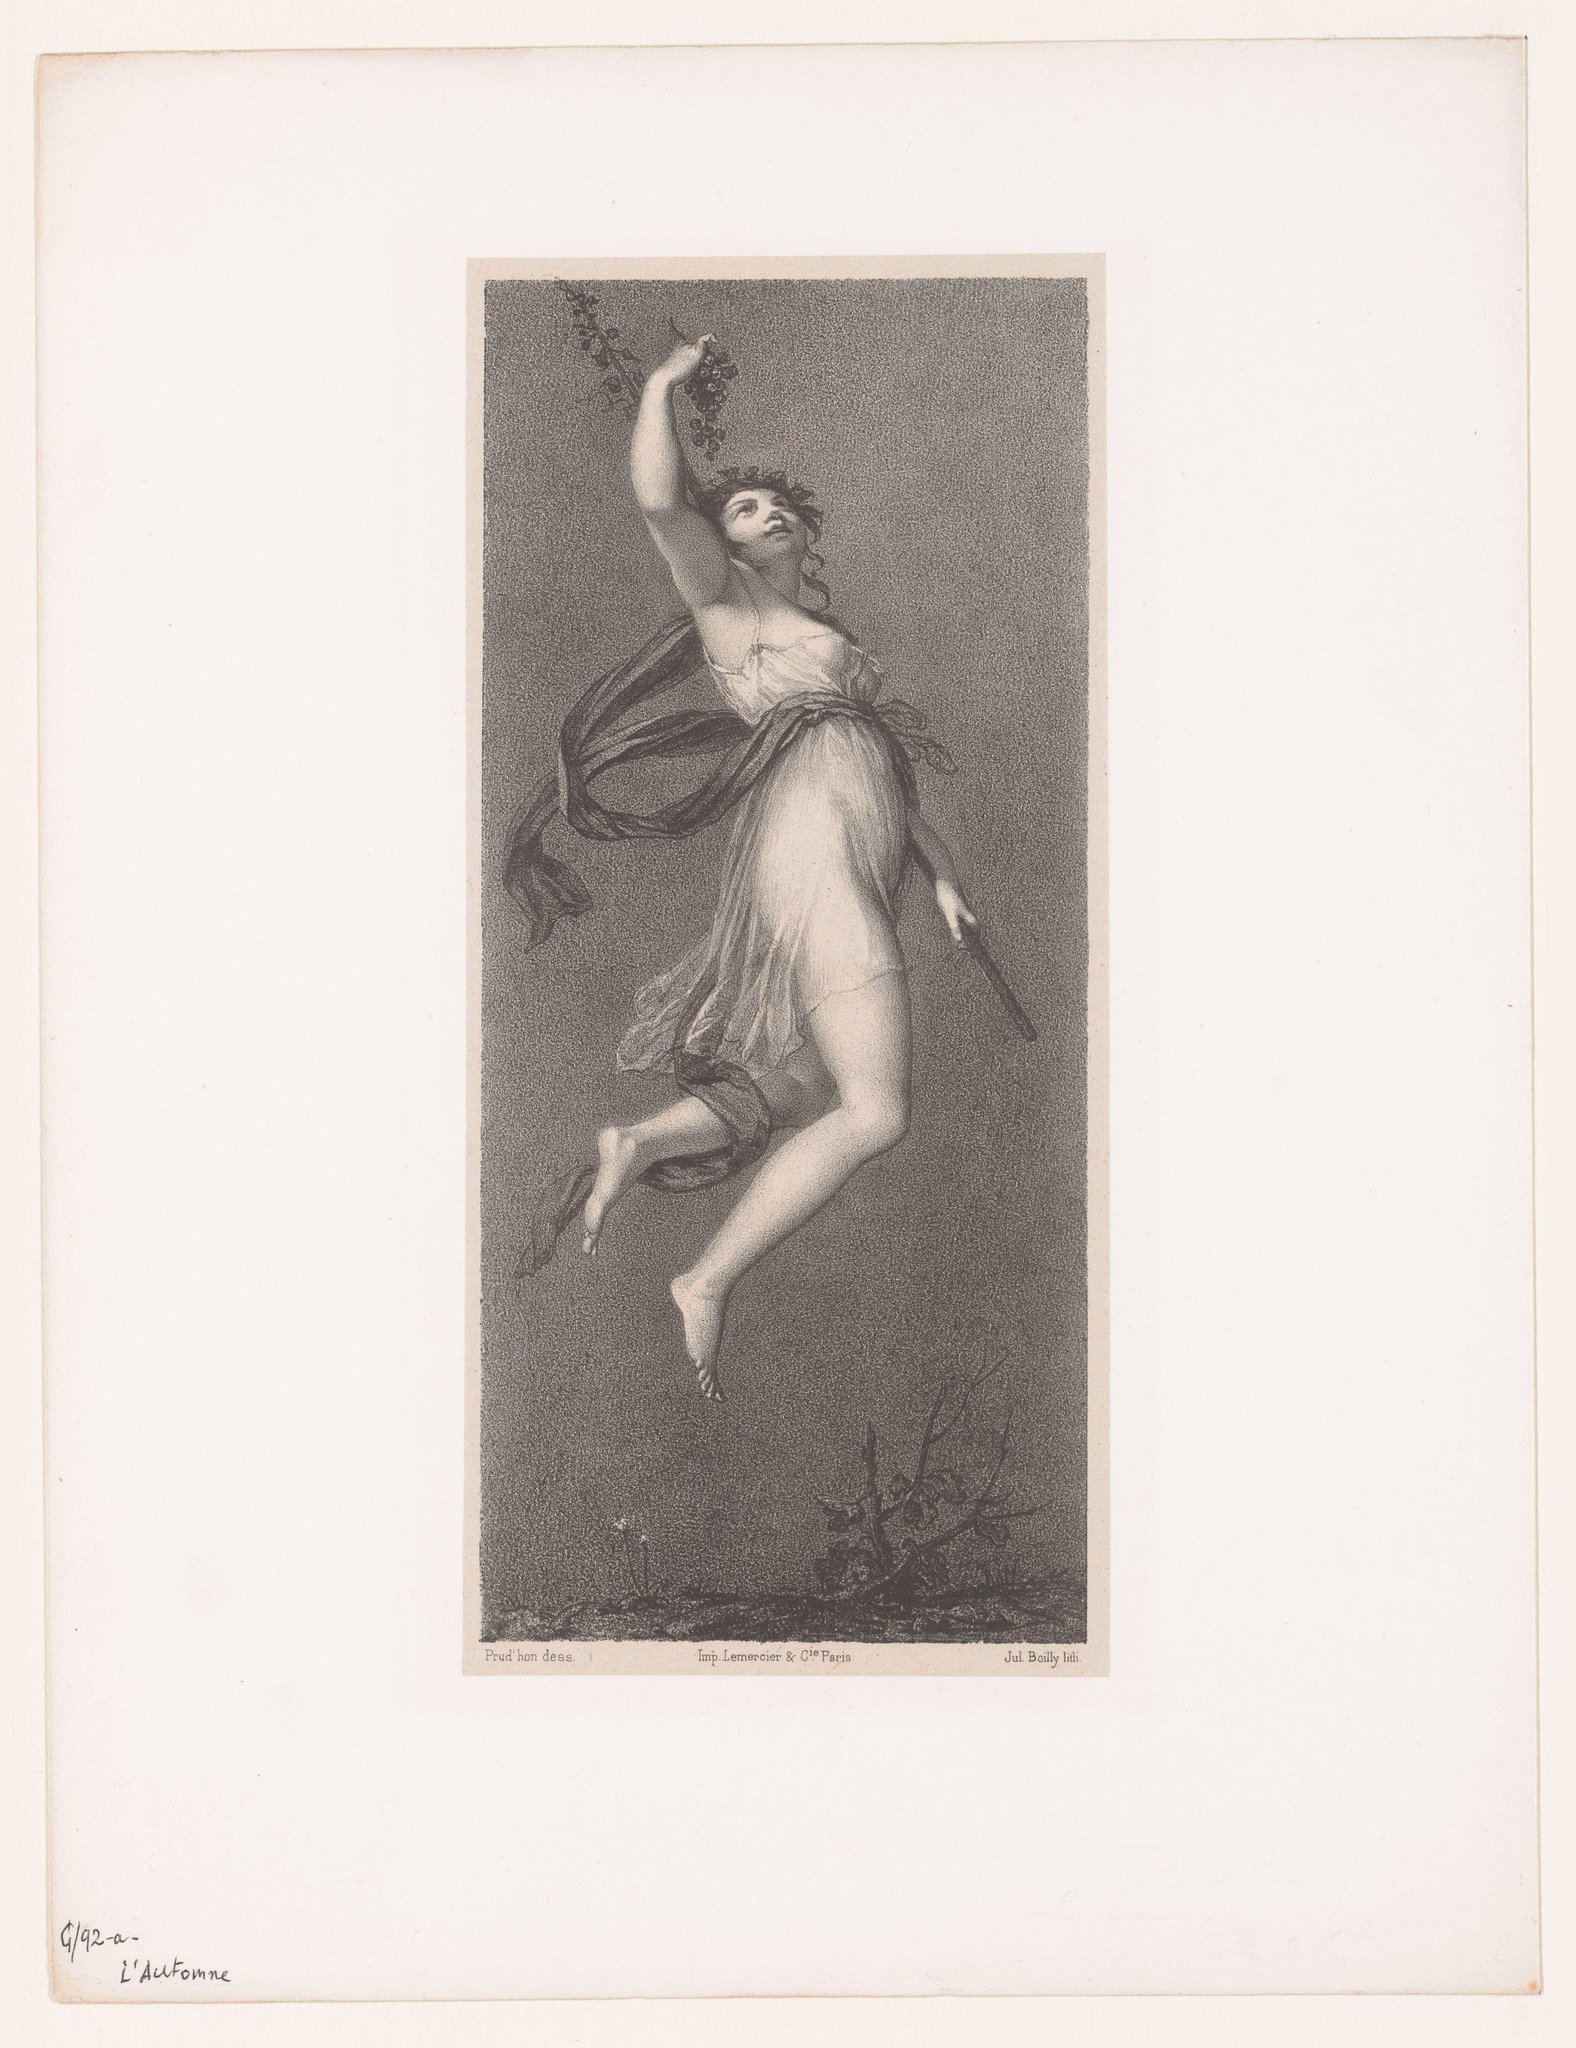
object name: print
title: L'Automne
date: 1811-1867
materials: paper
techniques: lithograph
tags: autumn, fall, 'autumnus'; 'autunno' (ripa)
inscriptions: collector's mark: Lugt 2760, collector's mark: Lugt 2228